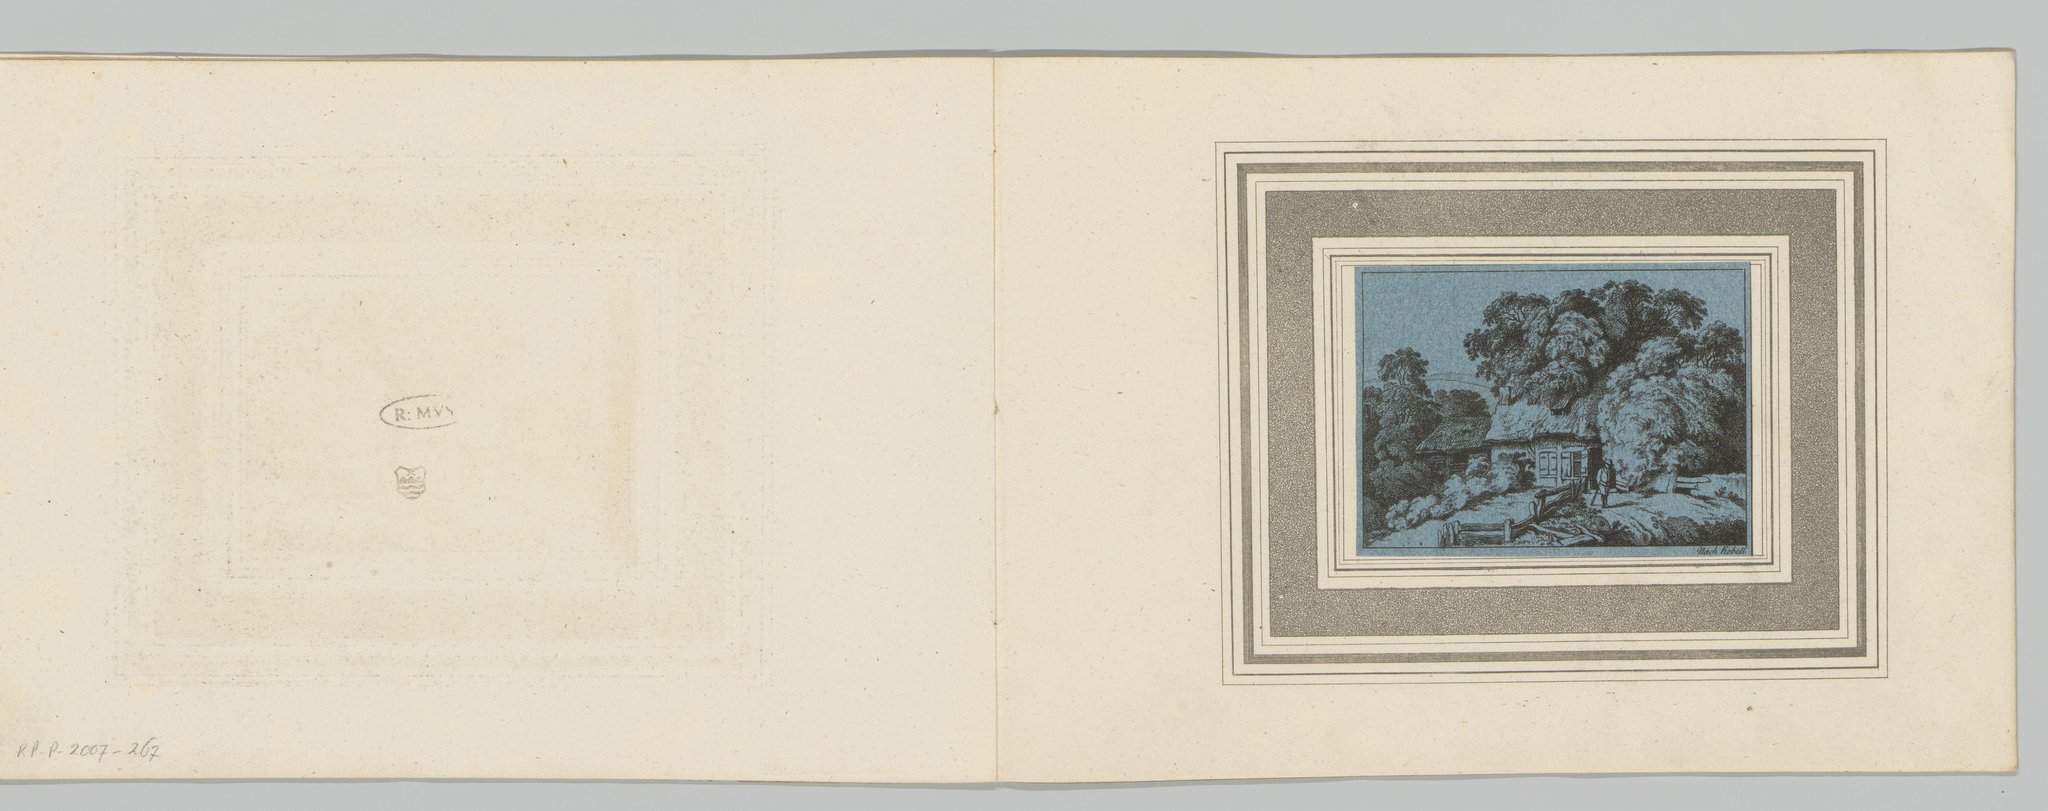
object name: print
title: 120 Radierungen nach F. Kobell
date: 1772-1828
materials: paper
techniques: etching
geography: vienna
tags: walking-stick, staff, landscapes in the temperate zone, 'en route', traveller under way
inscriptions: collector's mark: Lugt 2228, collector's mark: Lugt 2760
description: Vijfde prent in album 'VI Landschaften nach Kobell von K. Ponheimer IV. Heft' met zes prenten.